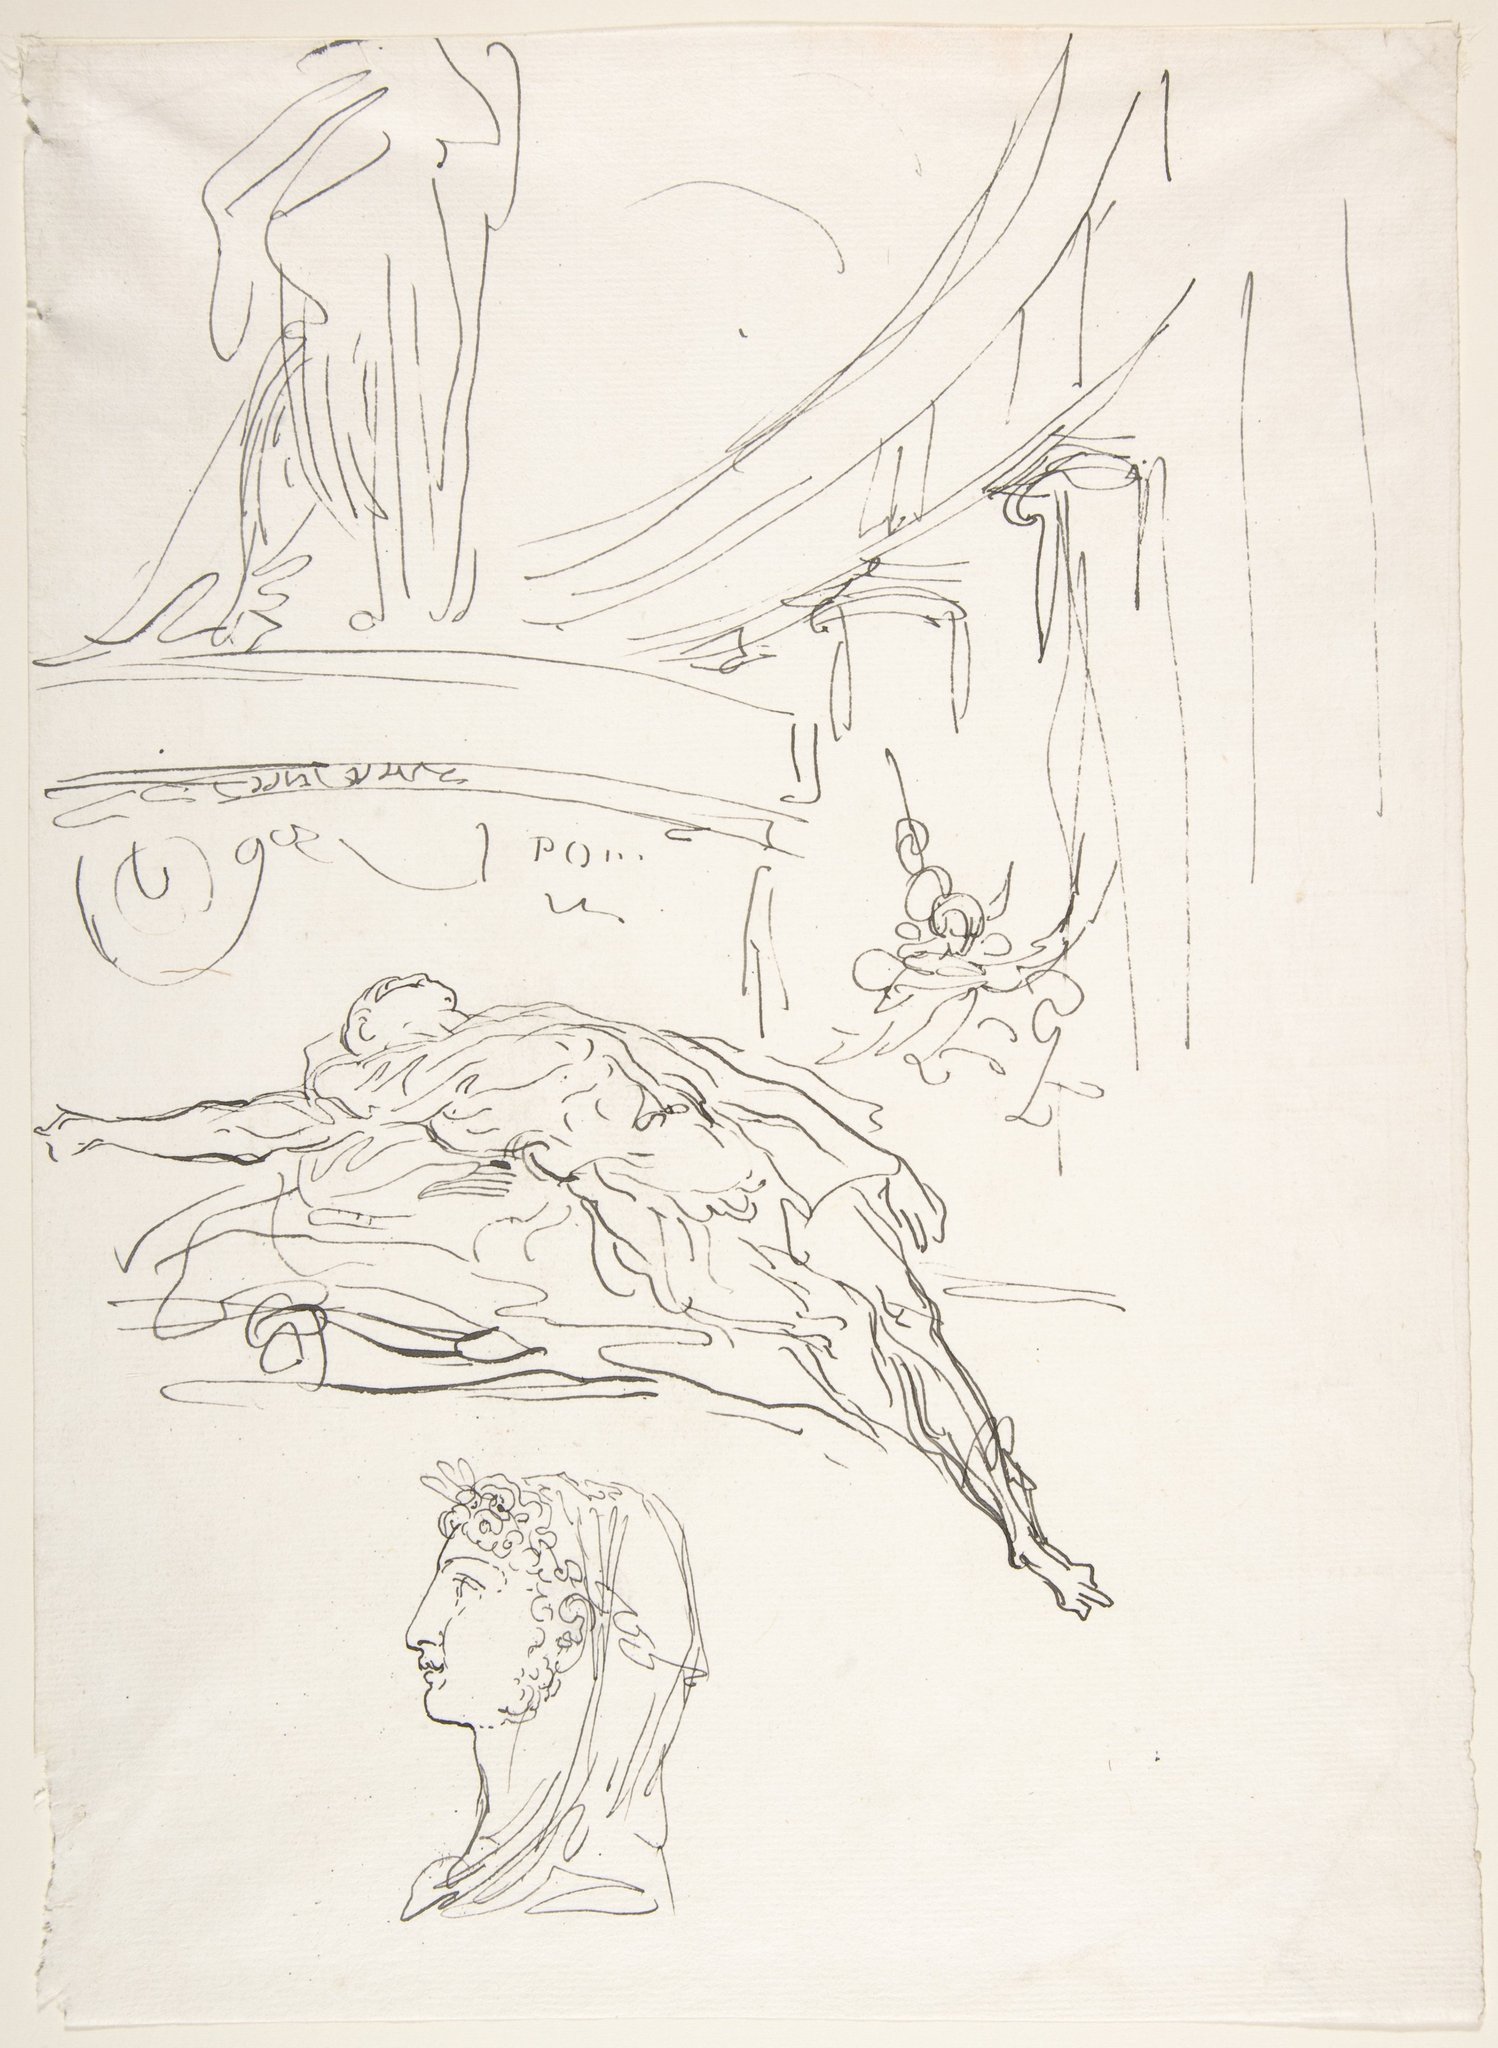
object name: drawing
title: Sheet of studies, including a Roman head, a male figure on a pyre, and a colonnade.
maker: luis paret y alcázar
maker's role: artist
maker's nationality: spanish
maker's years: 1746-1799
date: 1766-1774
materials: ink, paper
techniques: pen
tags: heads,men,profiles,women